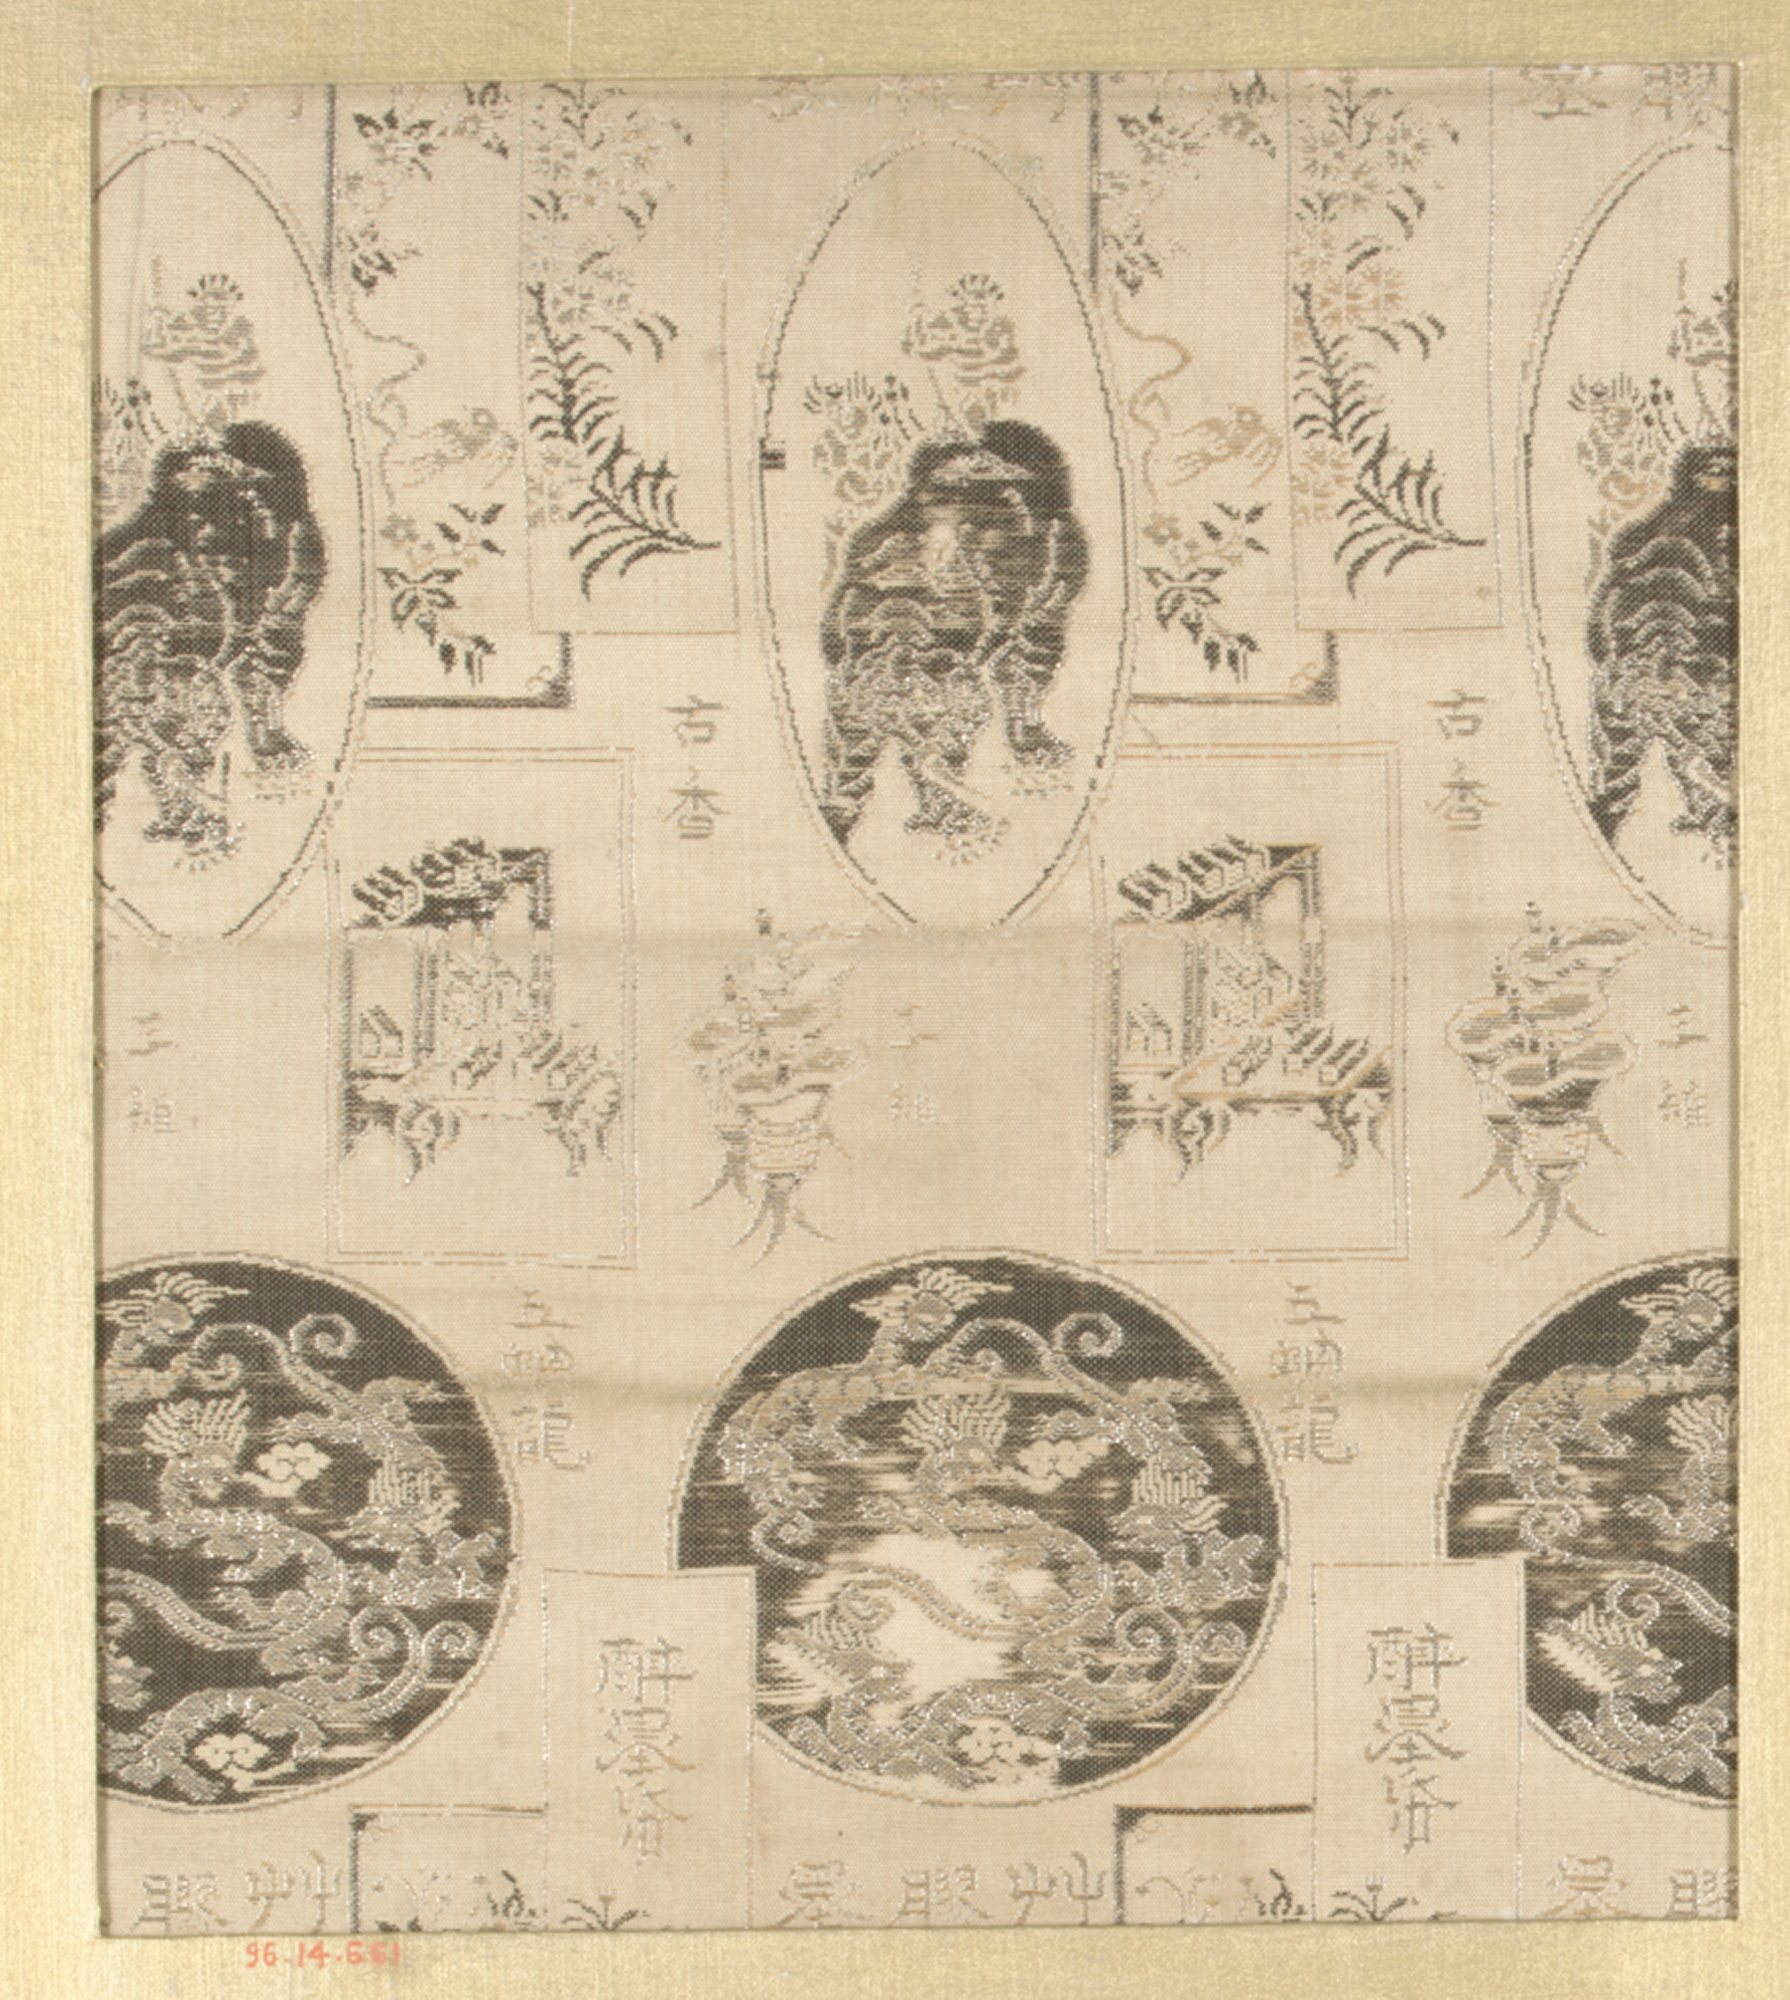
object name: piece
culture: japanese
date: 1701-1900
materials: silk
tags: human figures,dragons